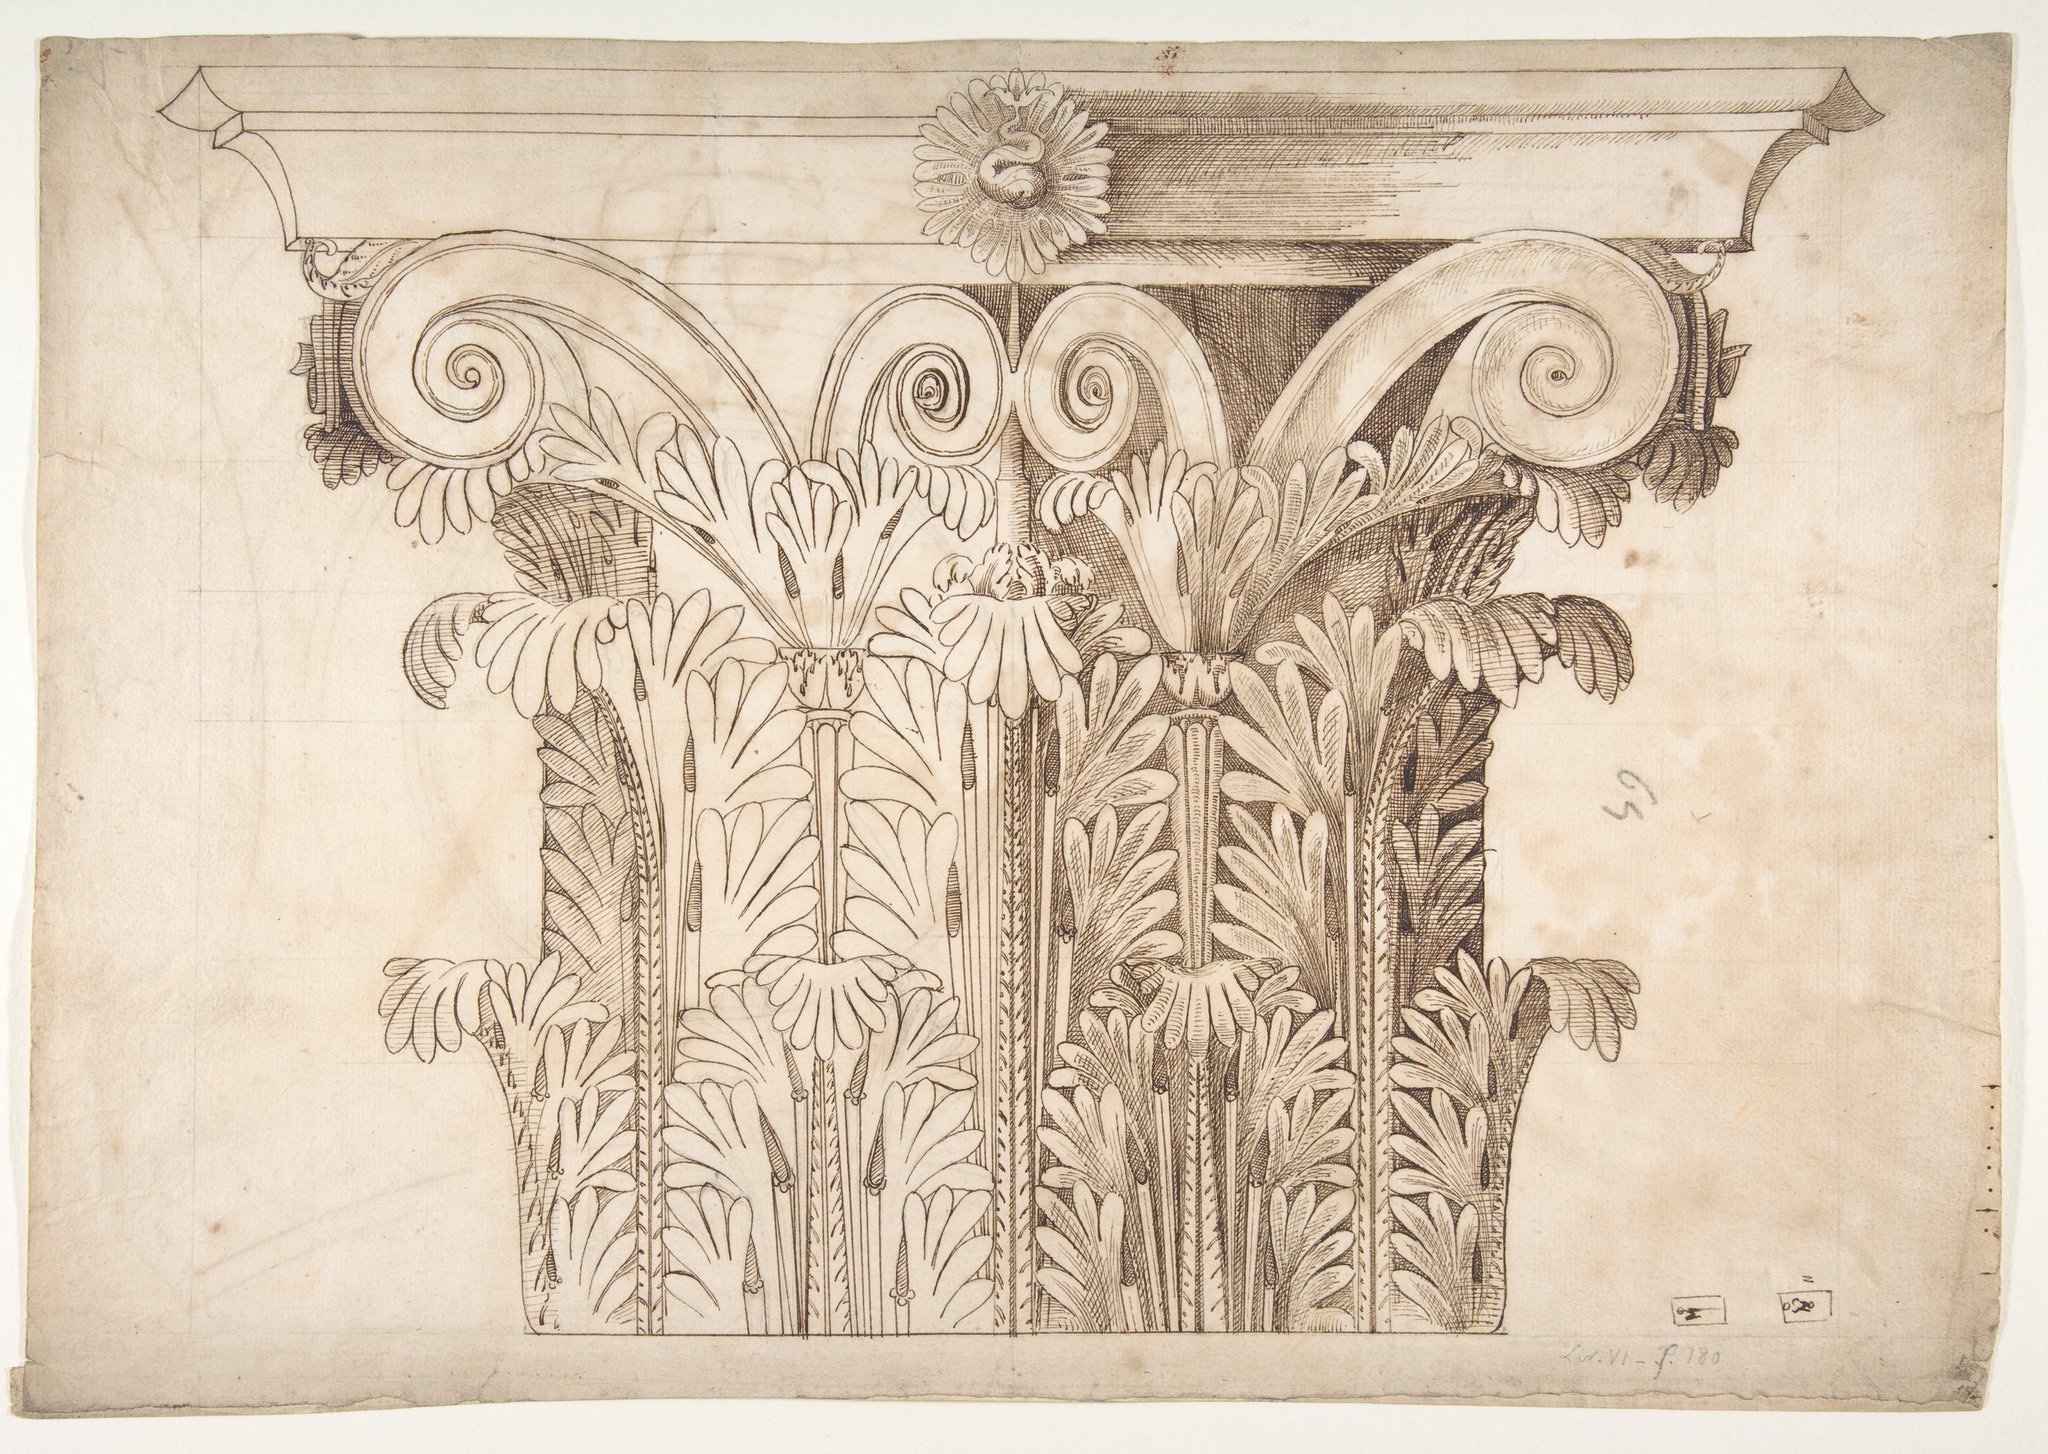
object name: collection ornament architecture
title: Unknown, Corinthian capital, elevation (recto) Unknown, Corinthian capital, plan diagram and detail (verso)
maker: anonymous, french, 16th century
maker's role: draftsman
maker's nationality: french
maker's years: 1500-1600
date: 1540-1560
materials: chalk, ink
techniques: incising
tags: capitals